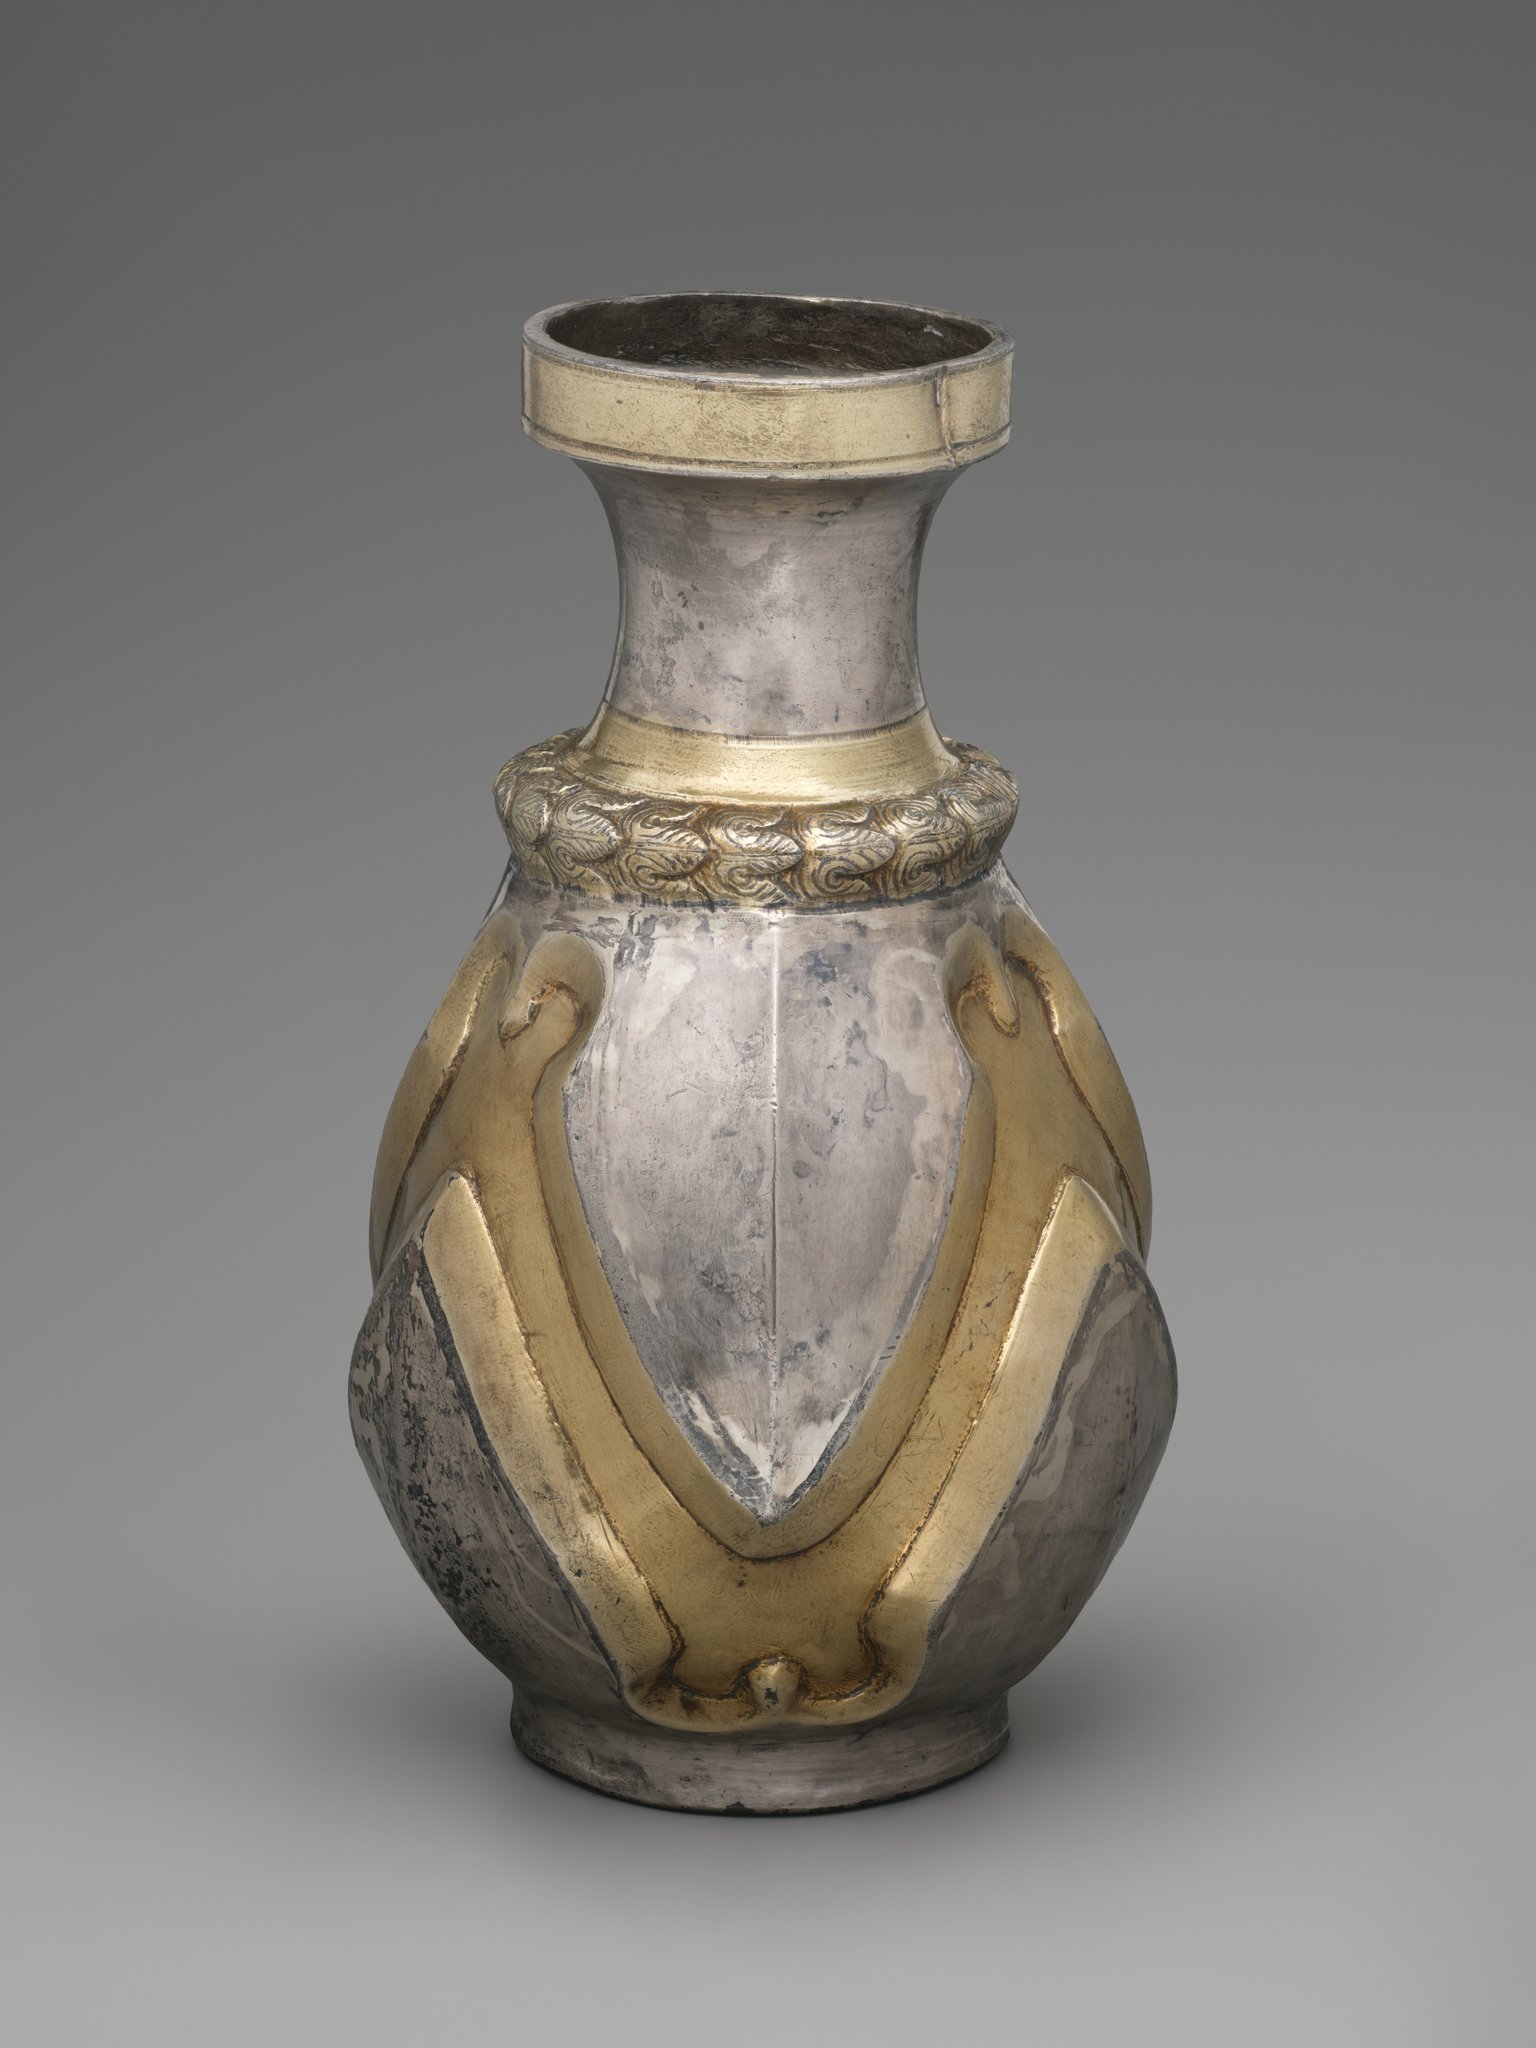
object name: vessel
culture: sasanian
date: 501-700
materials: mercury, silver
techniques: gilding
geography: iran